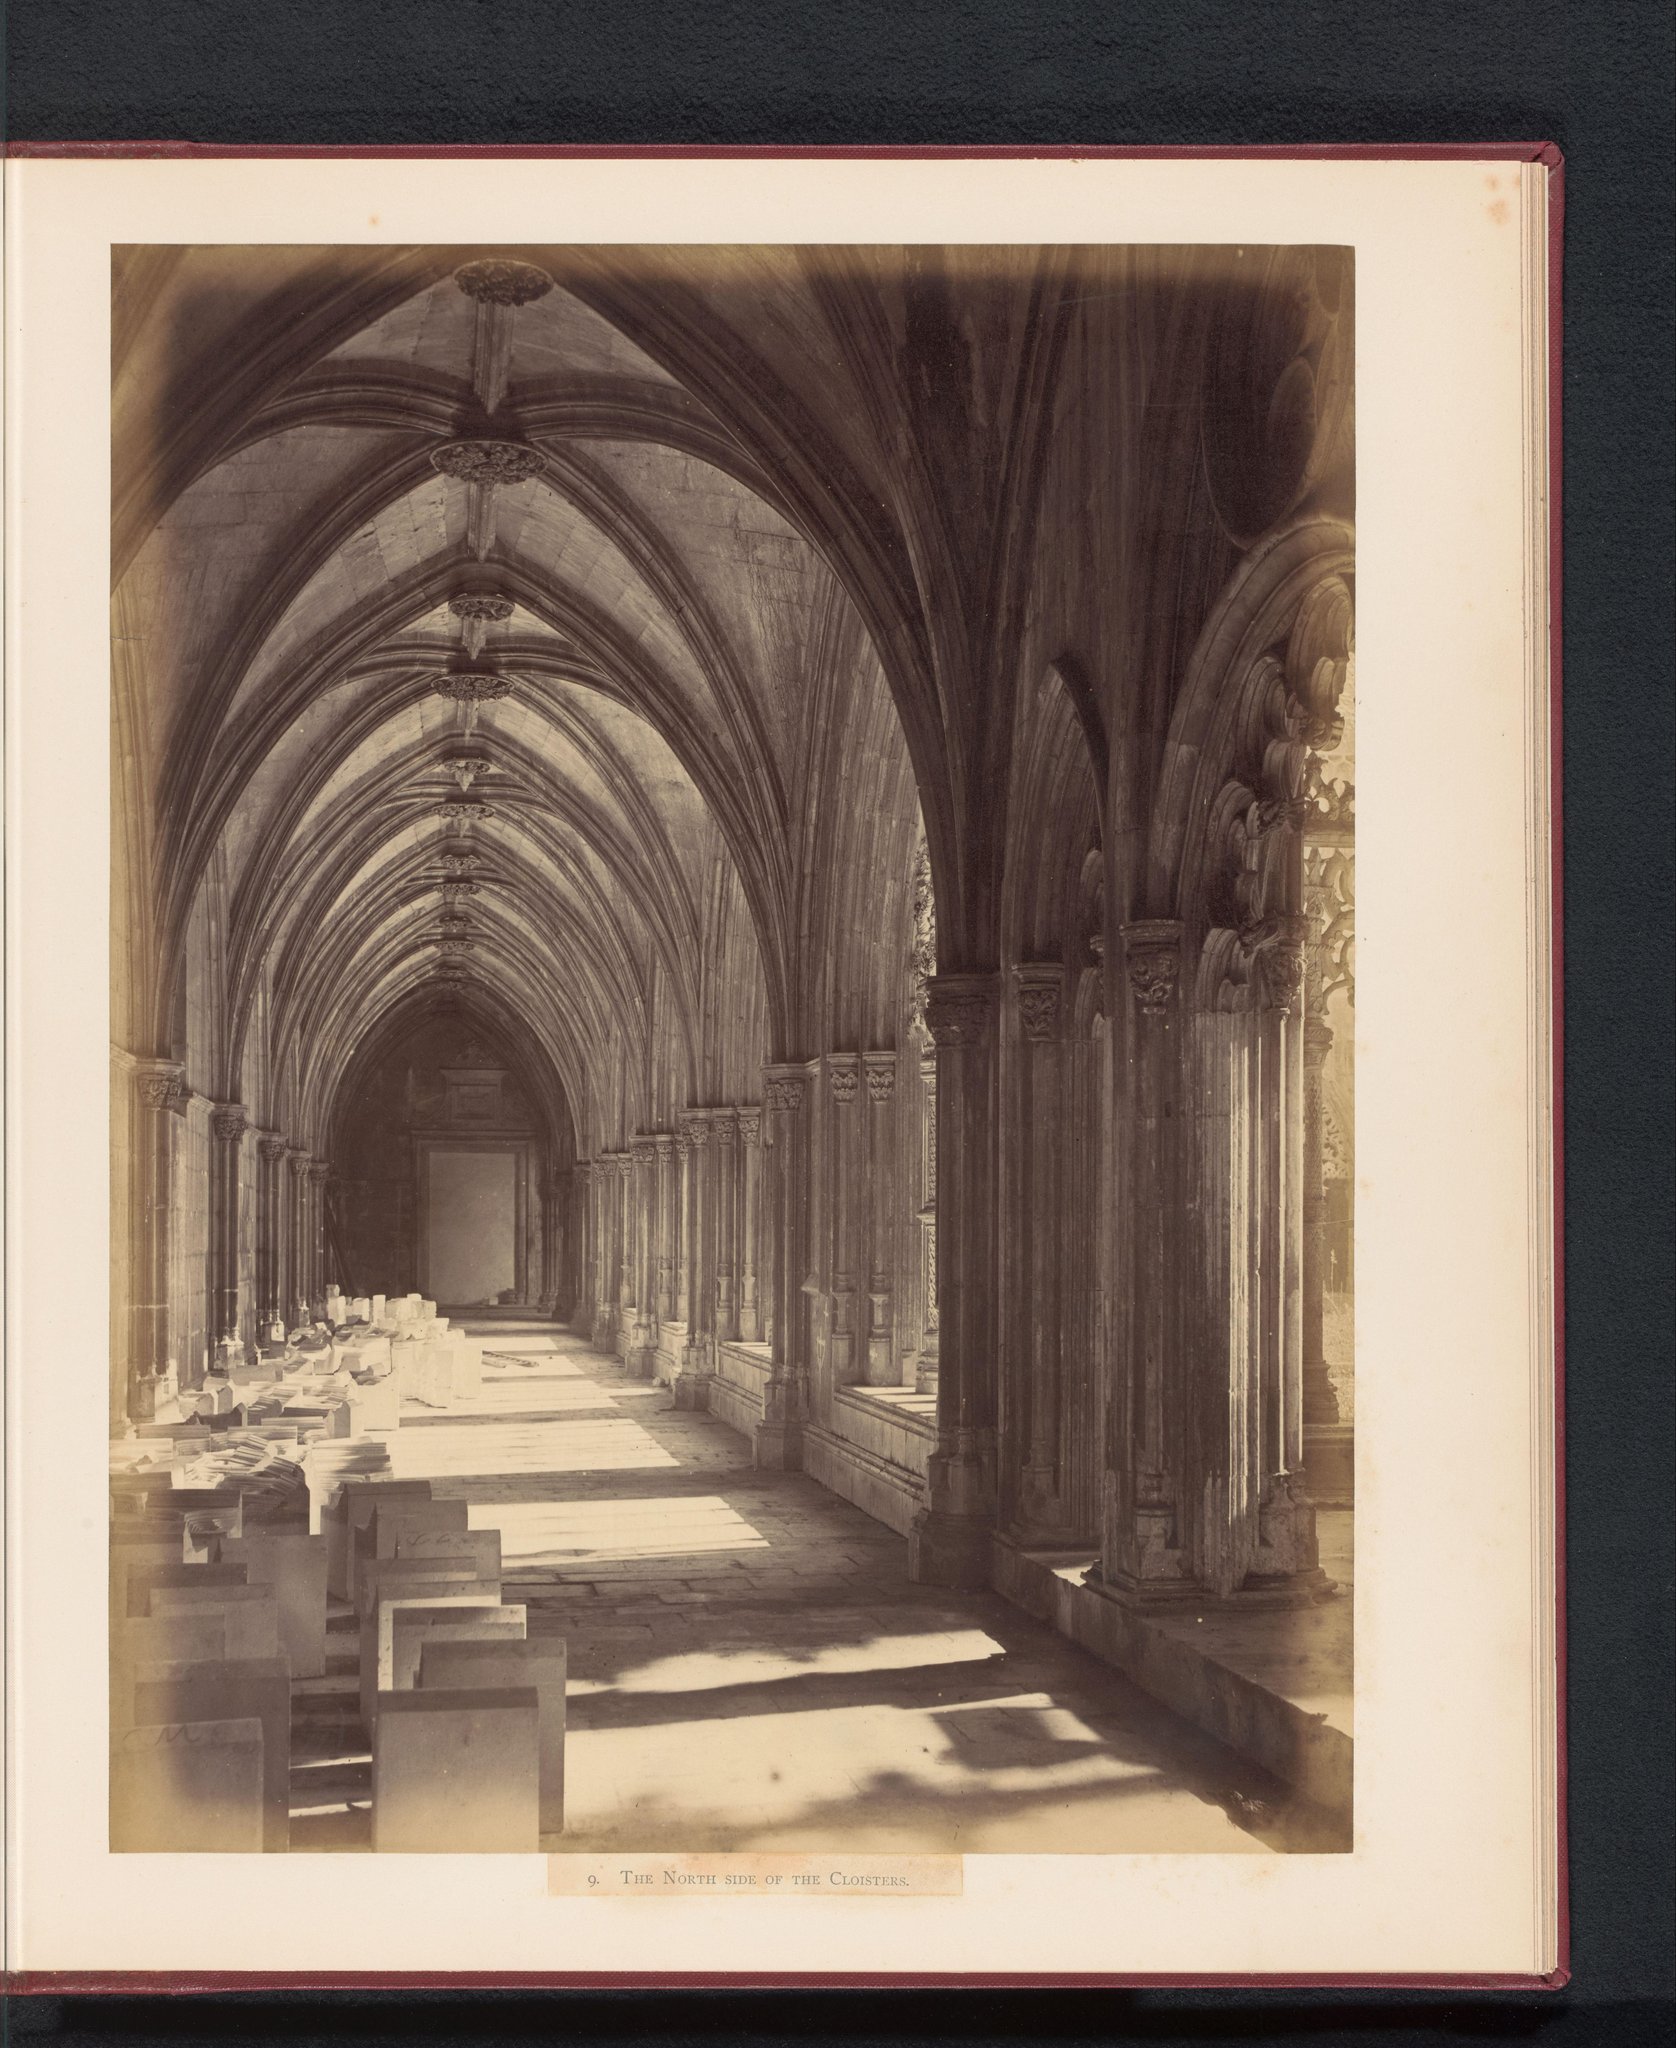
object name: photograph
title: Gezicht op een gang in het noordelijke deel van het klooster van Batalha, Portugal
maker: charles thurston thompson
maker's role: fotograaf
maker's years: 1816-1868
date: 1863-1868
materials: photographic support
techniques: albumen print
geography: batalha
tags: cloisters ~ monastery, gallery (spacious corridor)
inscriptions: number: ‘9.’